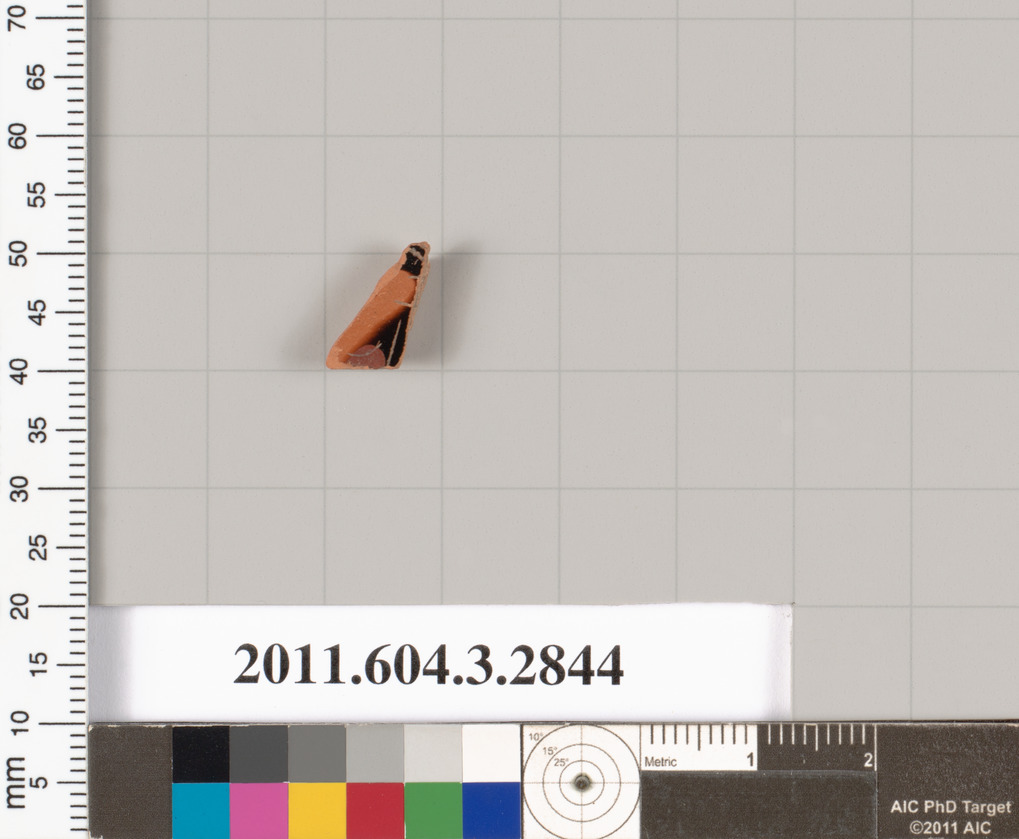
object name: undetermined closed shape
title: Terracotta fragment of a closed shape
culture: greek, attic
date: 534-468 BCE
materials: terracotta